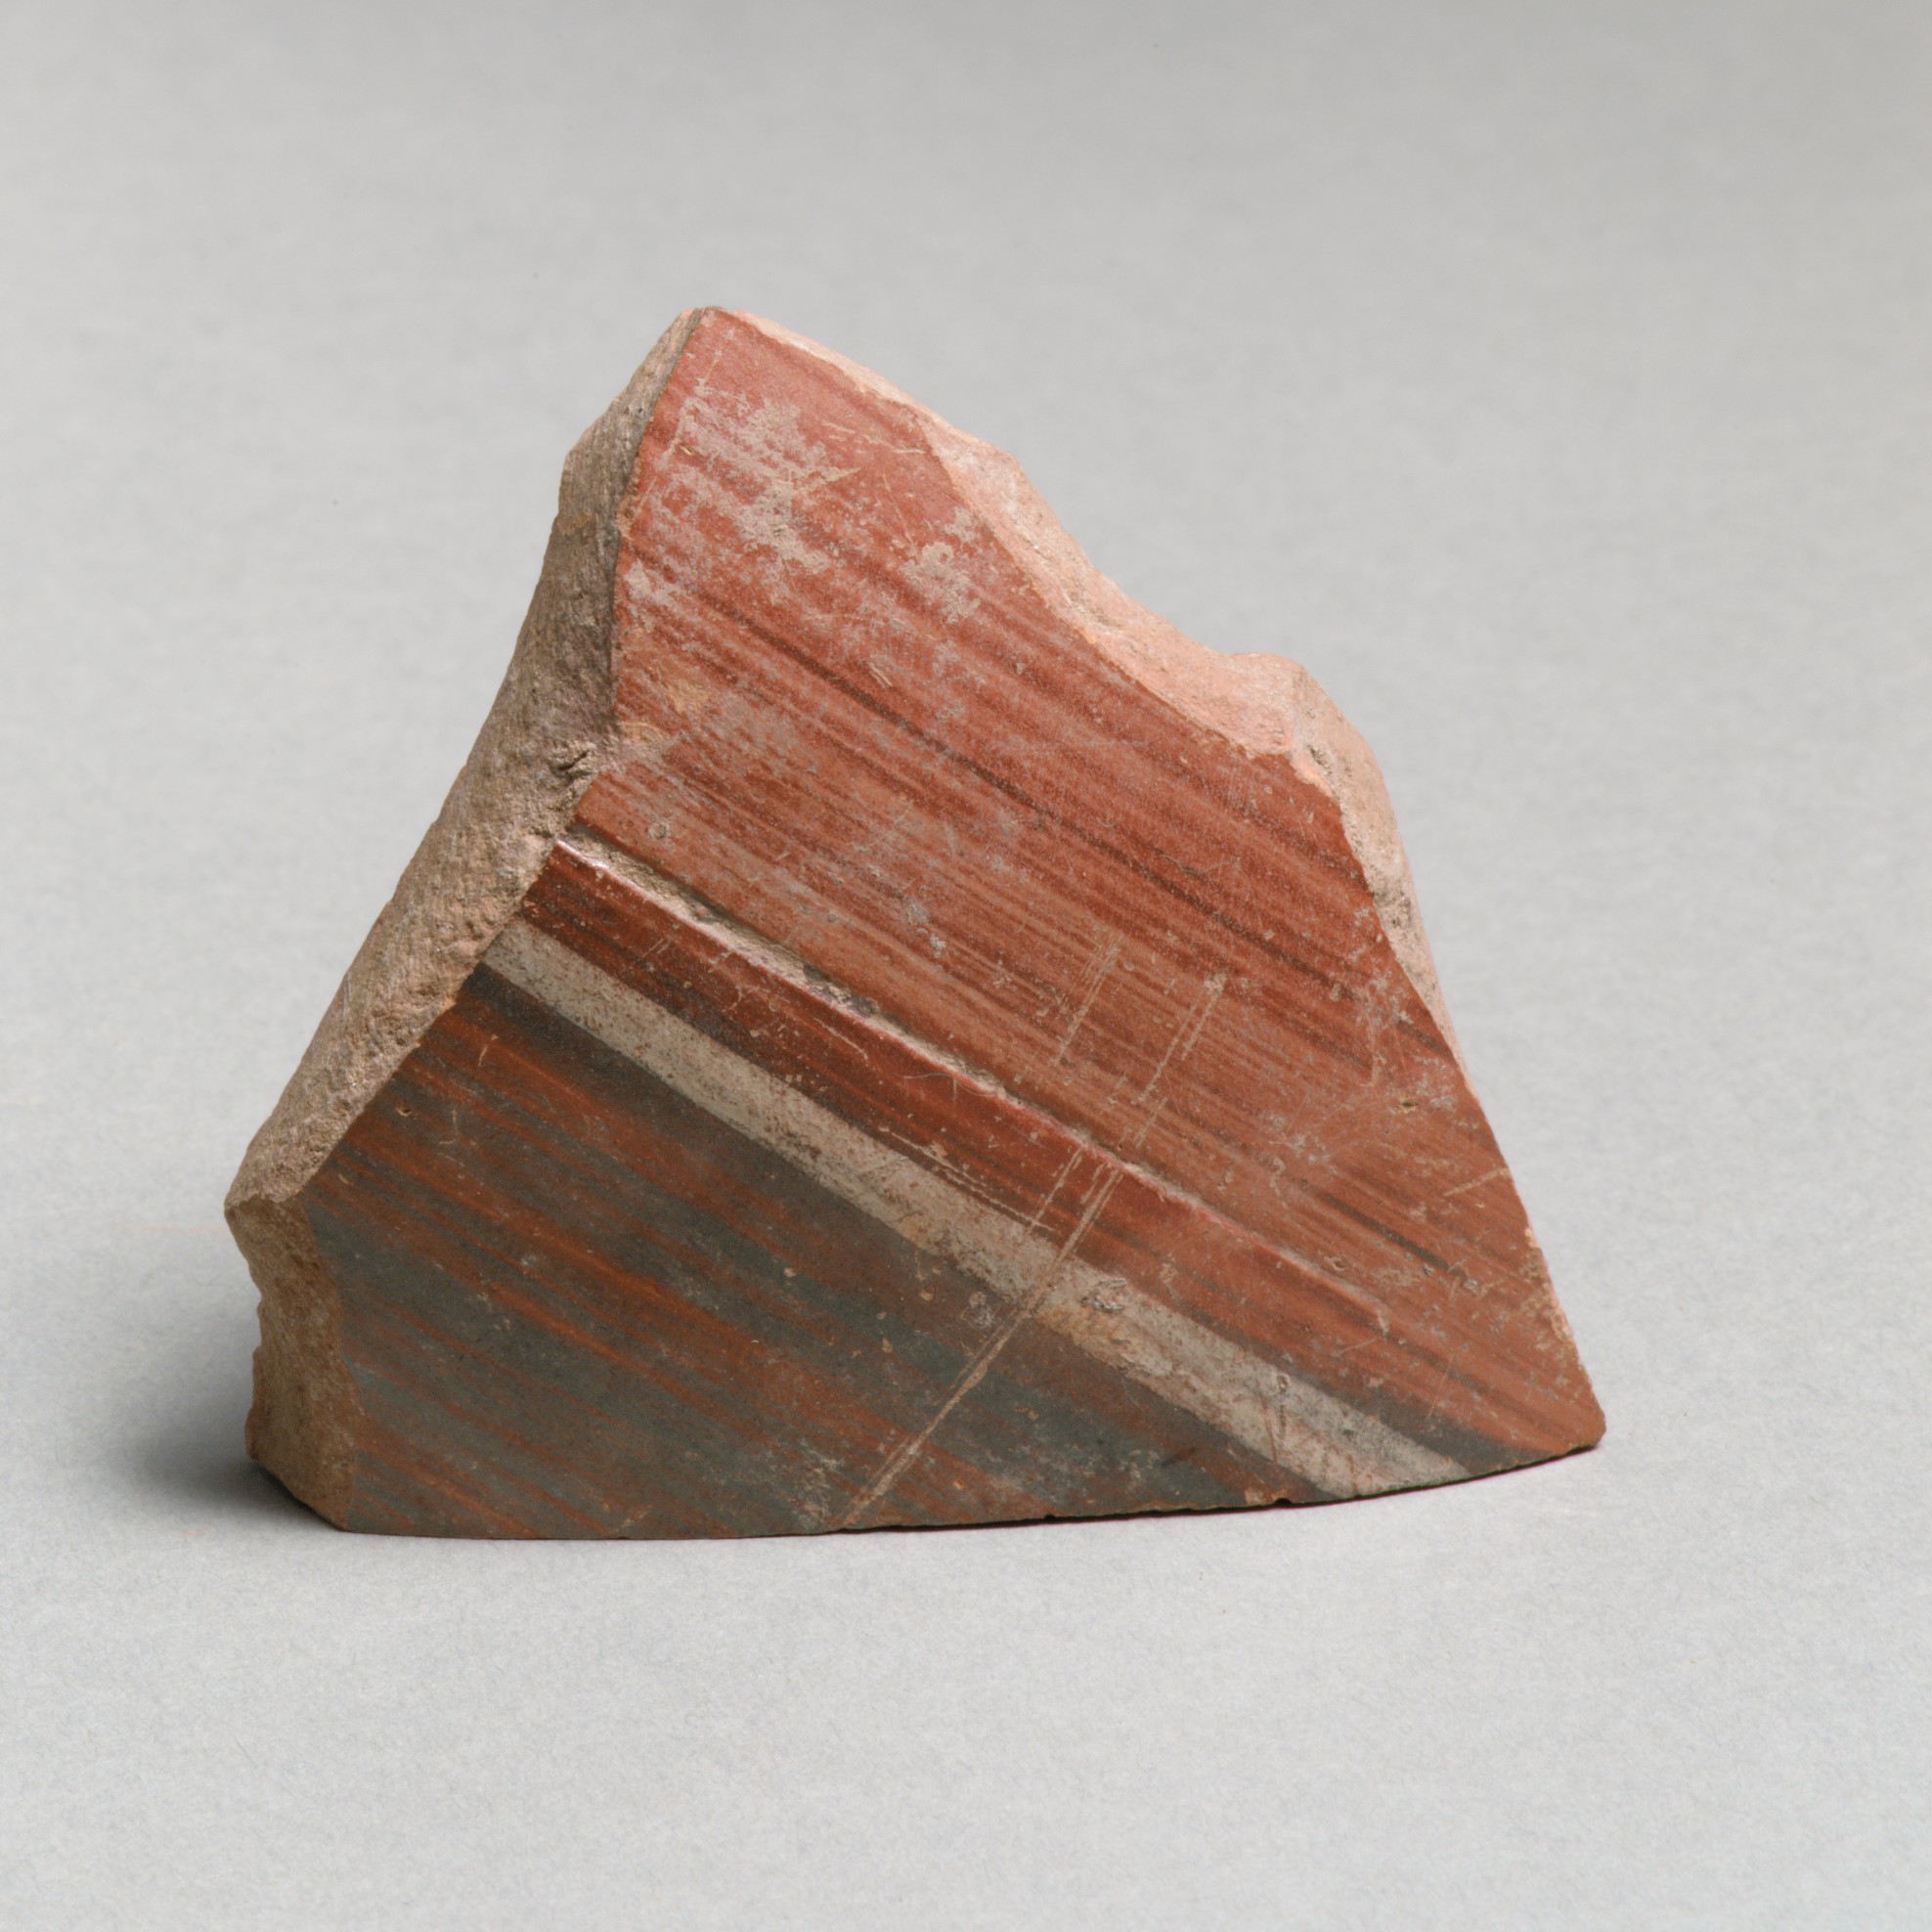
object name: vase fragment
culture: greek or lydian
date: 900-30 BCE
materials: terracotta